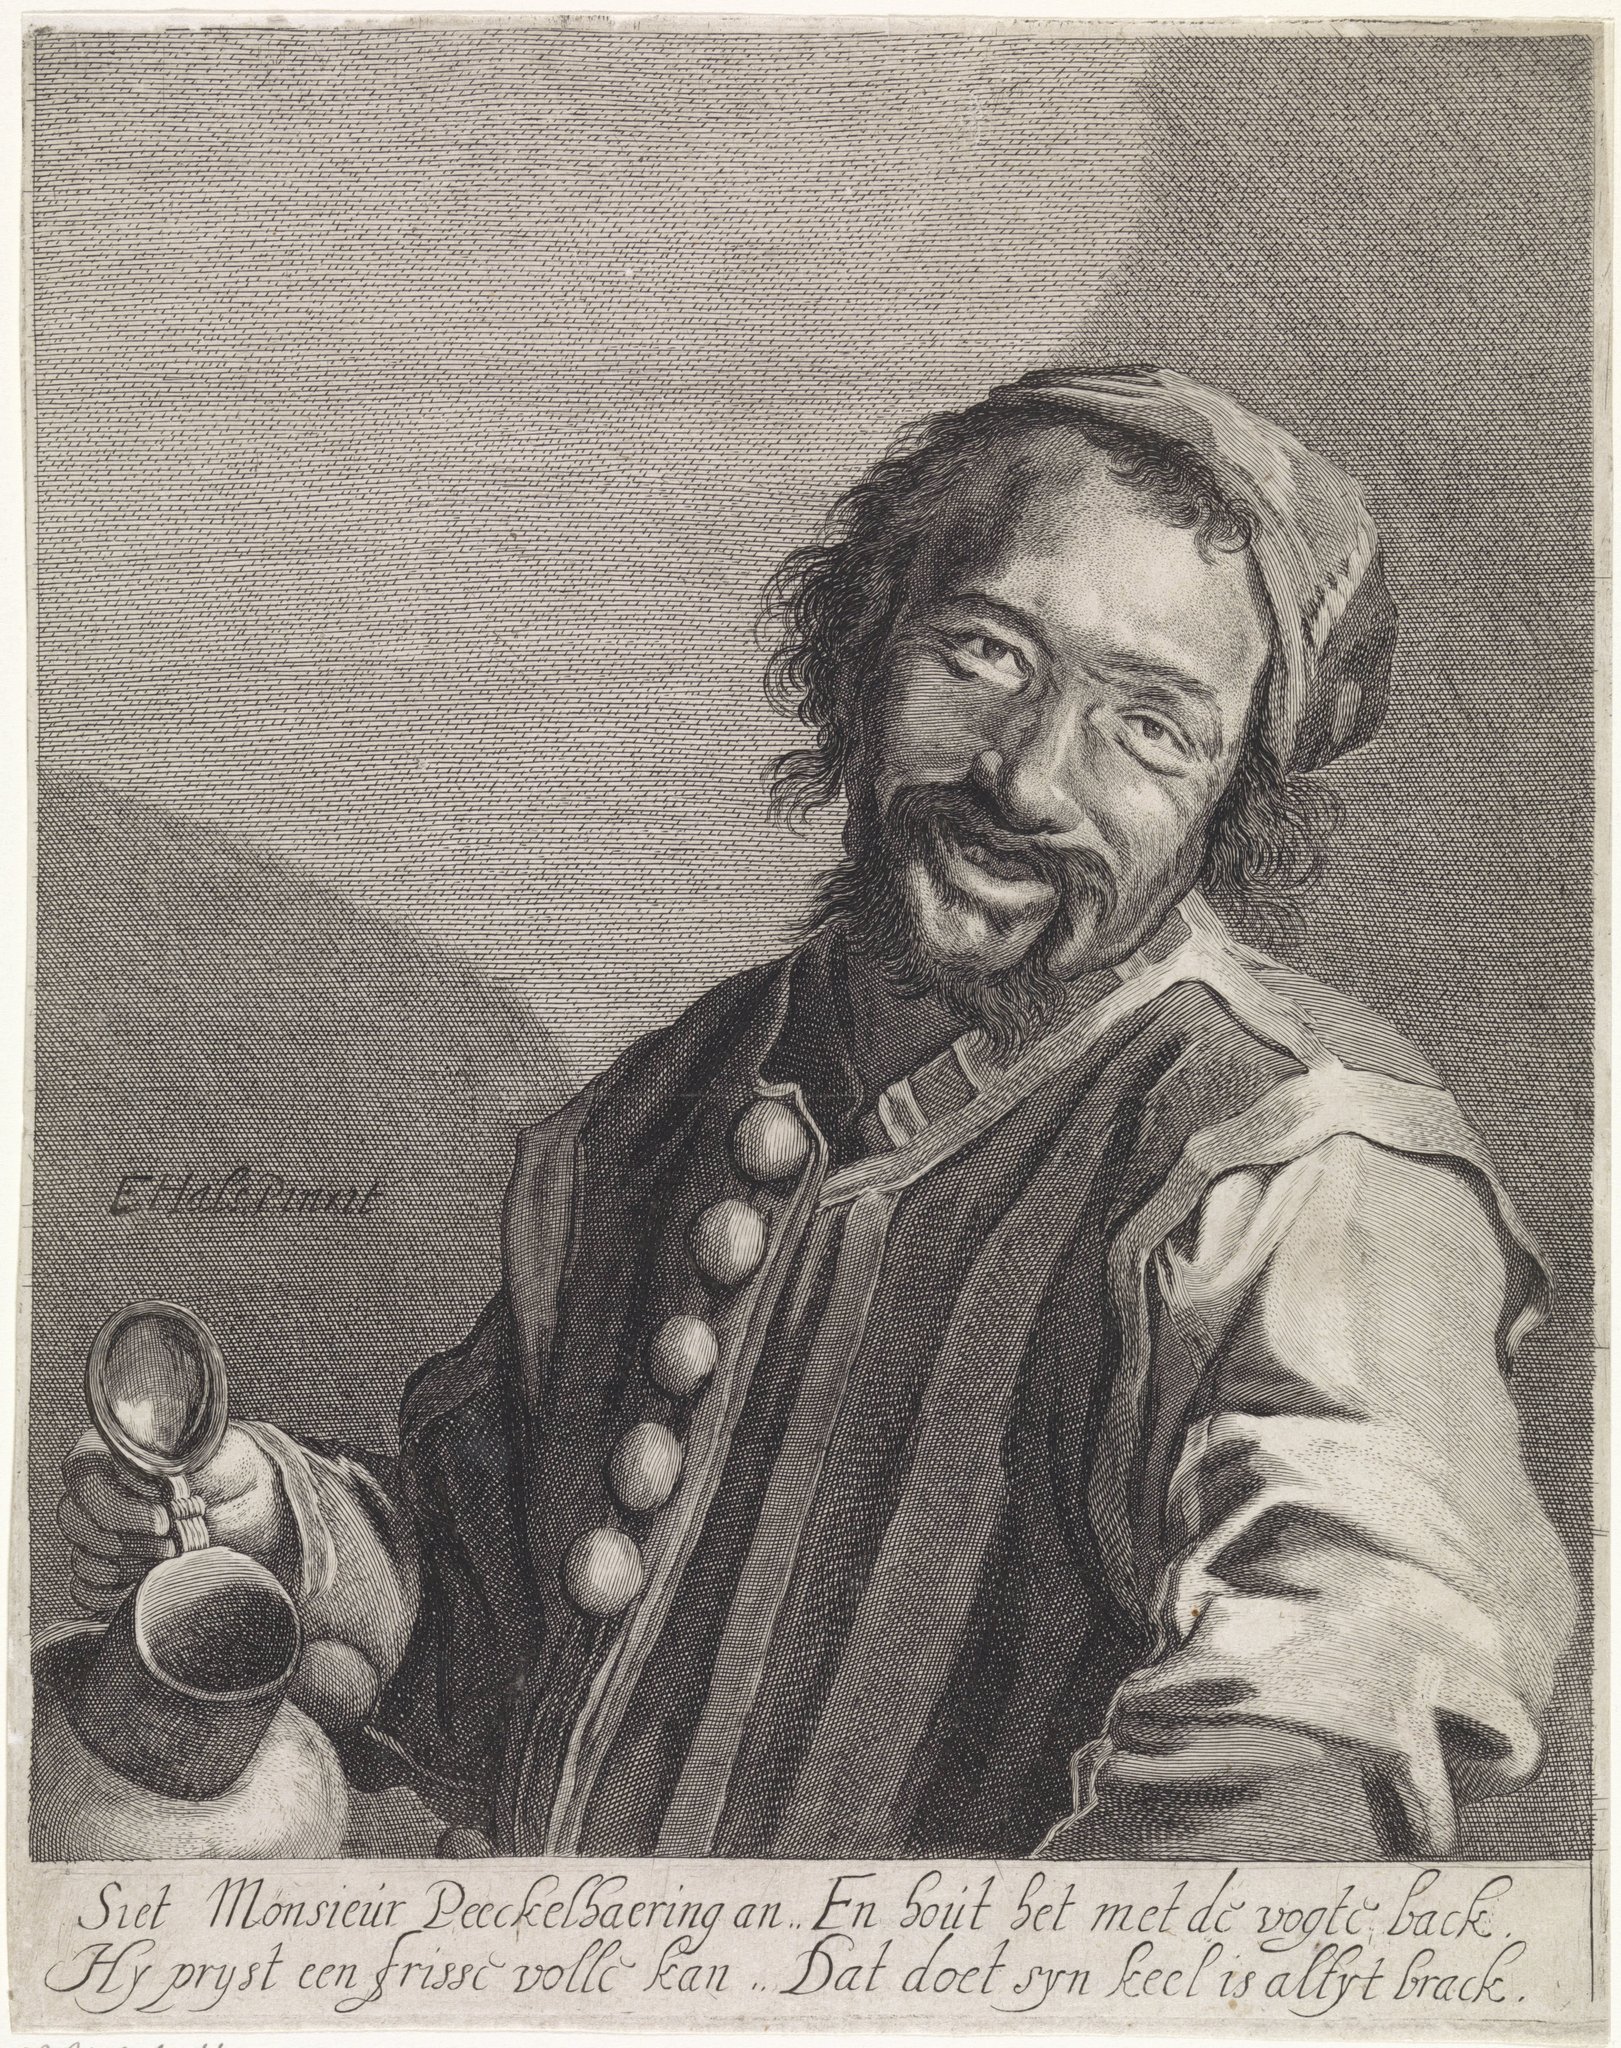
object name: print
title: Meneer 'Peeckelhaering'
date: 1630-1640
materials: paper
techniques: engraving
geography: haarlem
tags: jar, jug (used as drinking-vessel)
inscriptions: collector's mark: Lugt 240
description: Een lachende nar toont een geopende kan. Onderaan in de marge een vierregelig vers in het Nederlands over de voorgestelde 'meneer Peeckelhaering'.